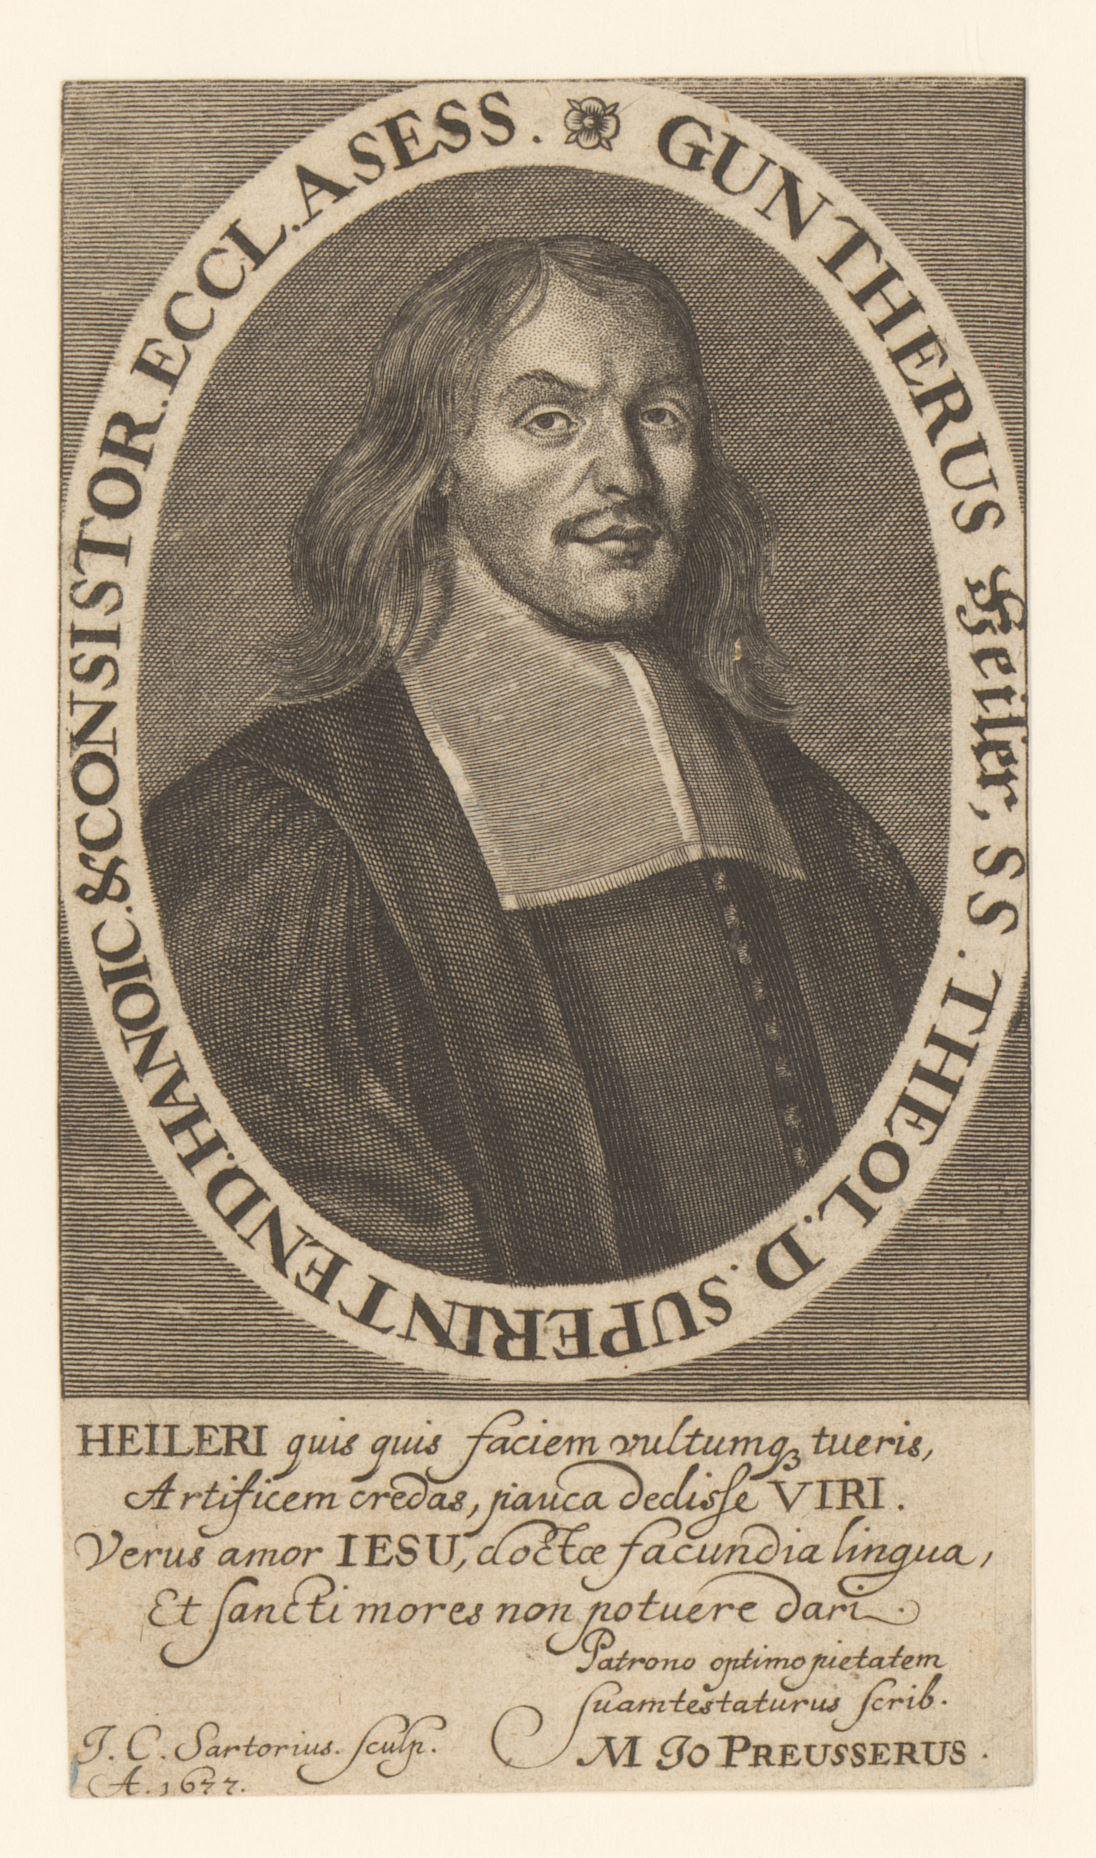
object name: print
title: Portret van Günther Heiler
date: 1680-1739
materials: paper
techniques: engraving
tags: theologian, historical persons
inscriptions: collector's mark: Lugt 2228